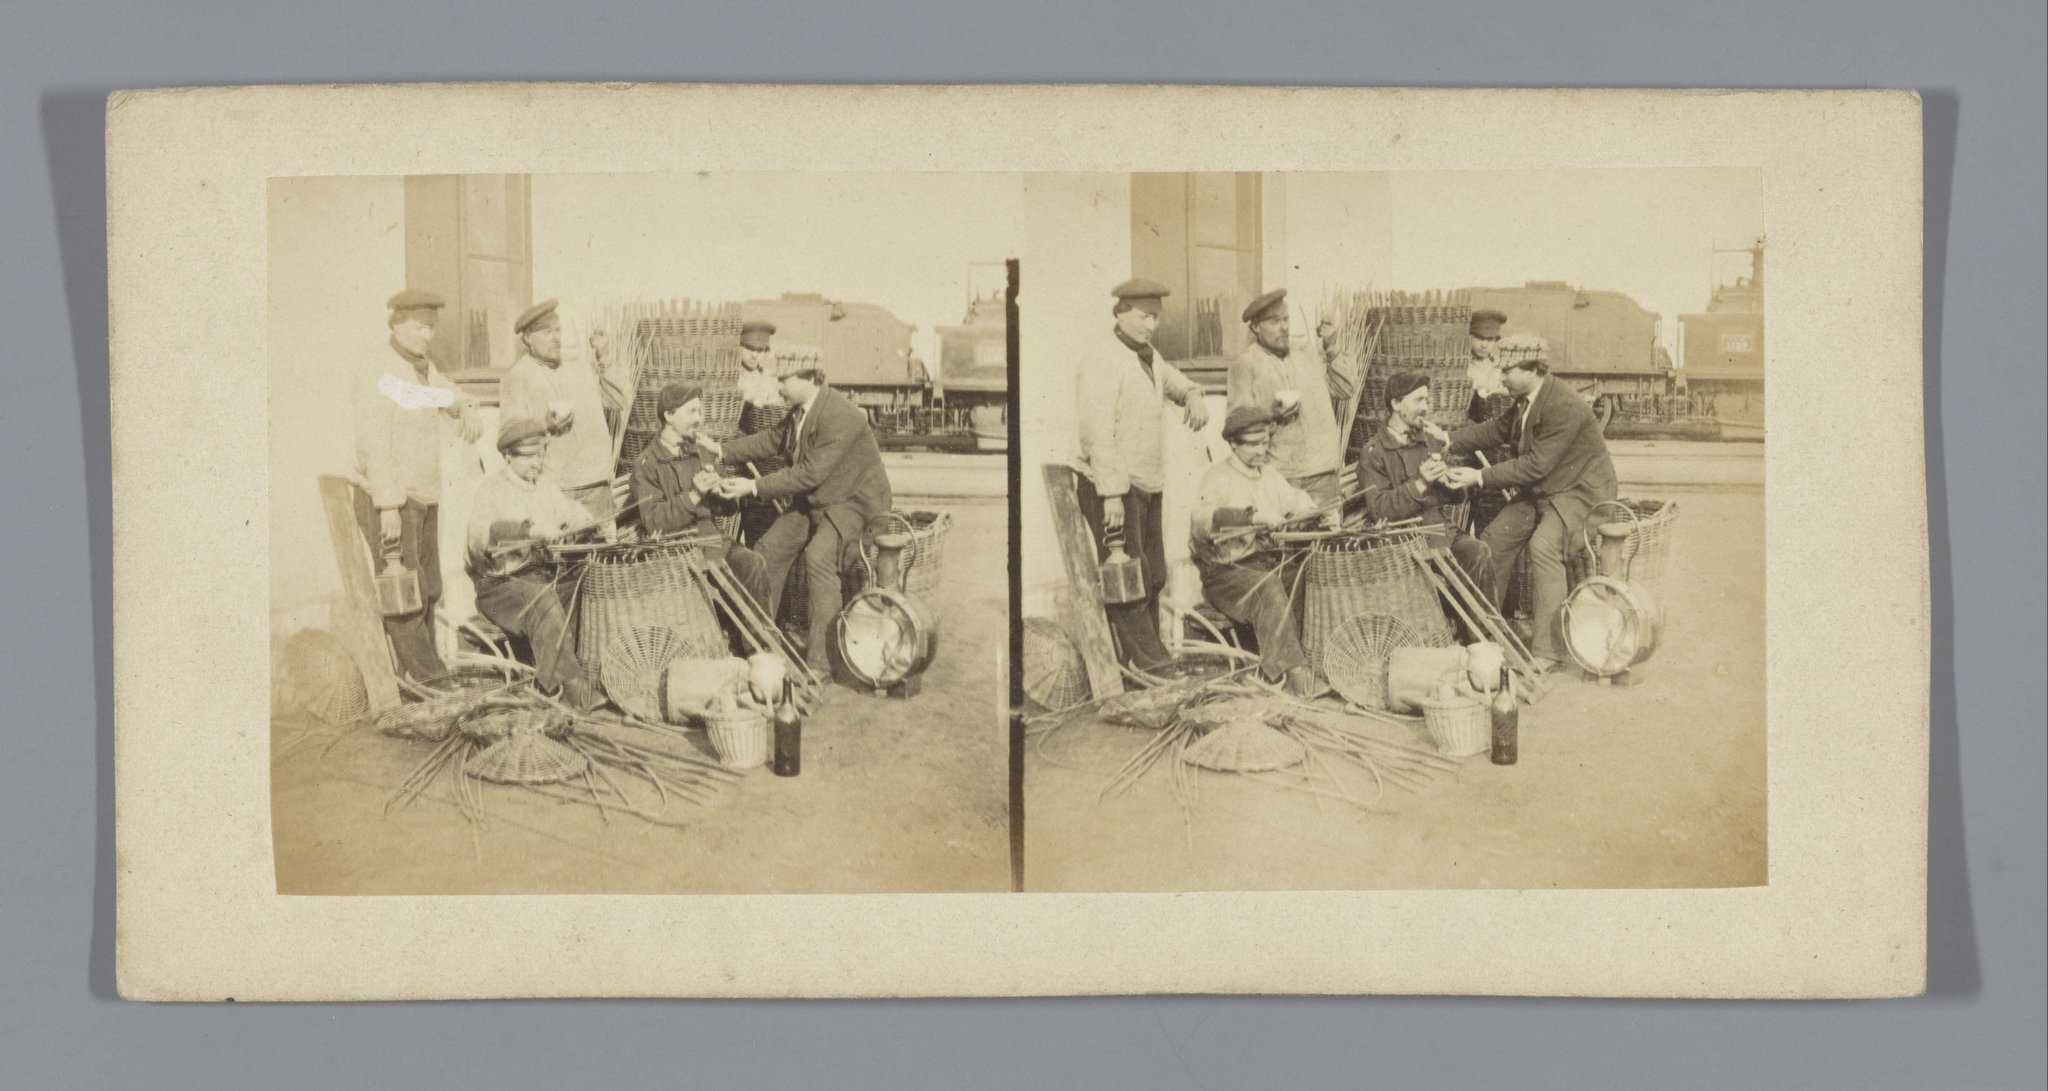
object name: stereograph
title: Mandvlechters op een straathoek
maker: Anonymous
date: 1850-1880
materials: cardboard, photographic support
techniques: albumen print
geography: europe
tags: container made of plant material other than wood: basket, street, europe